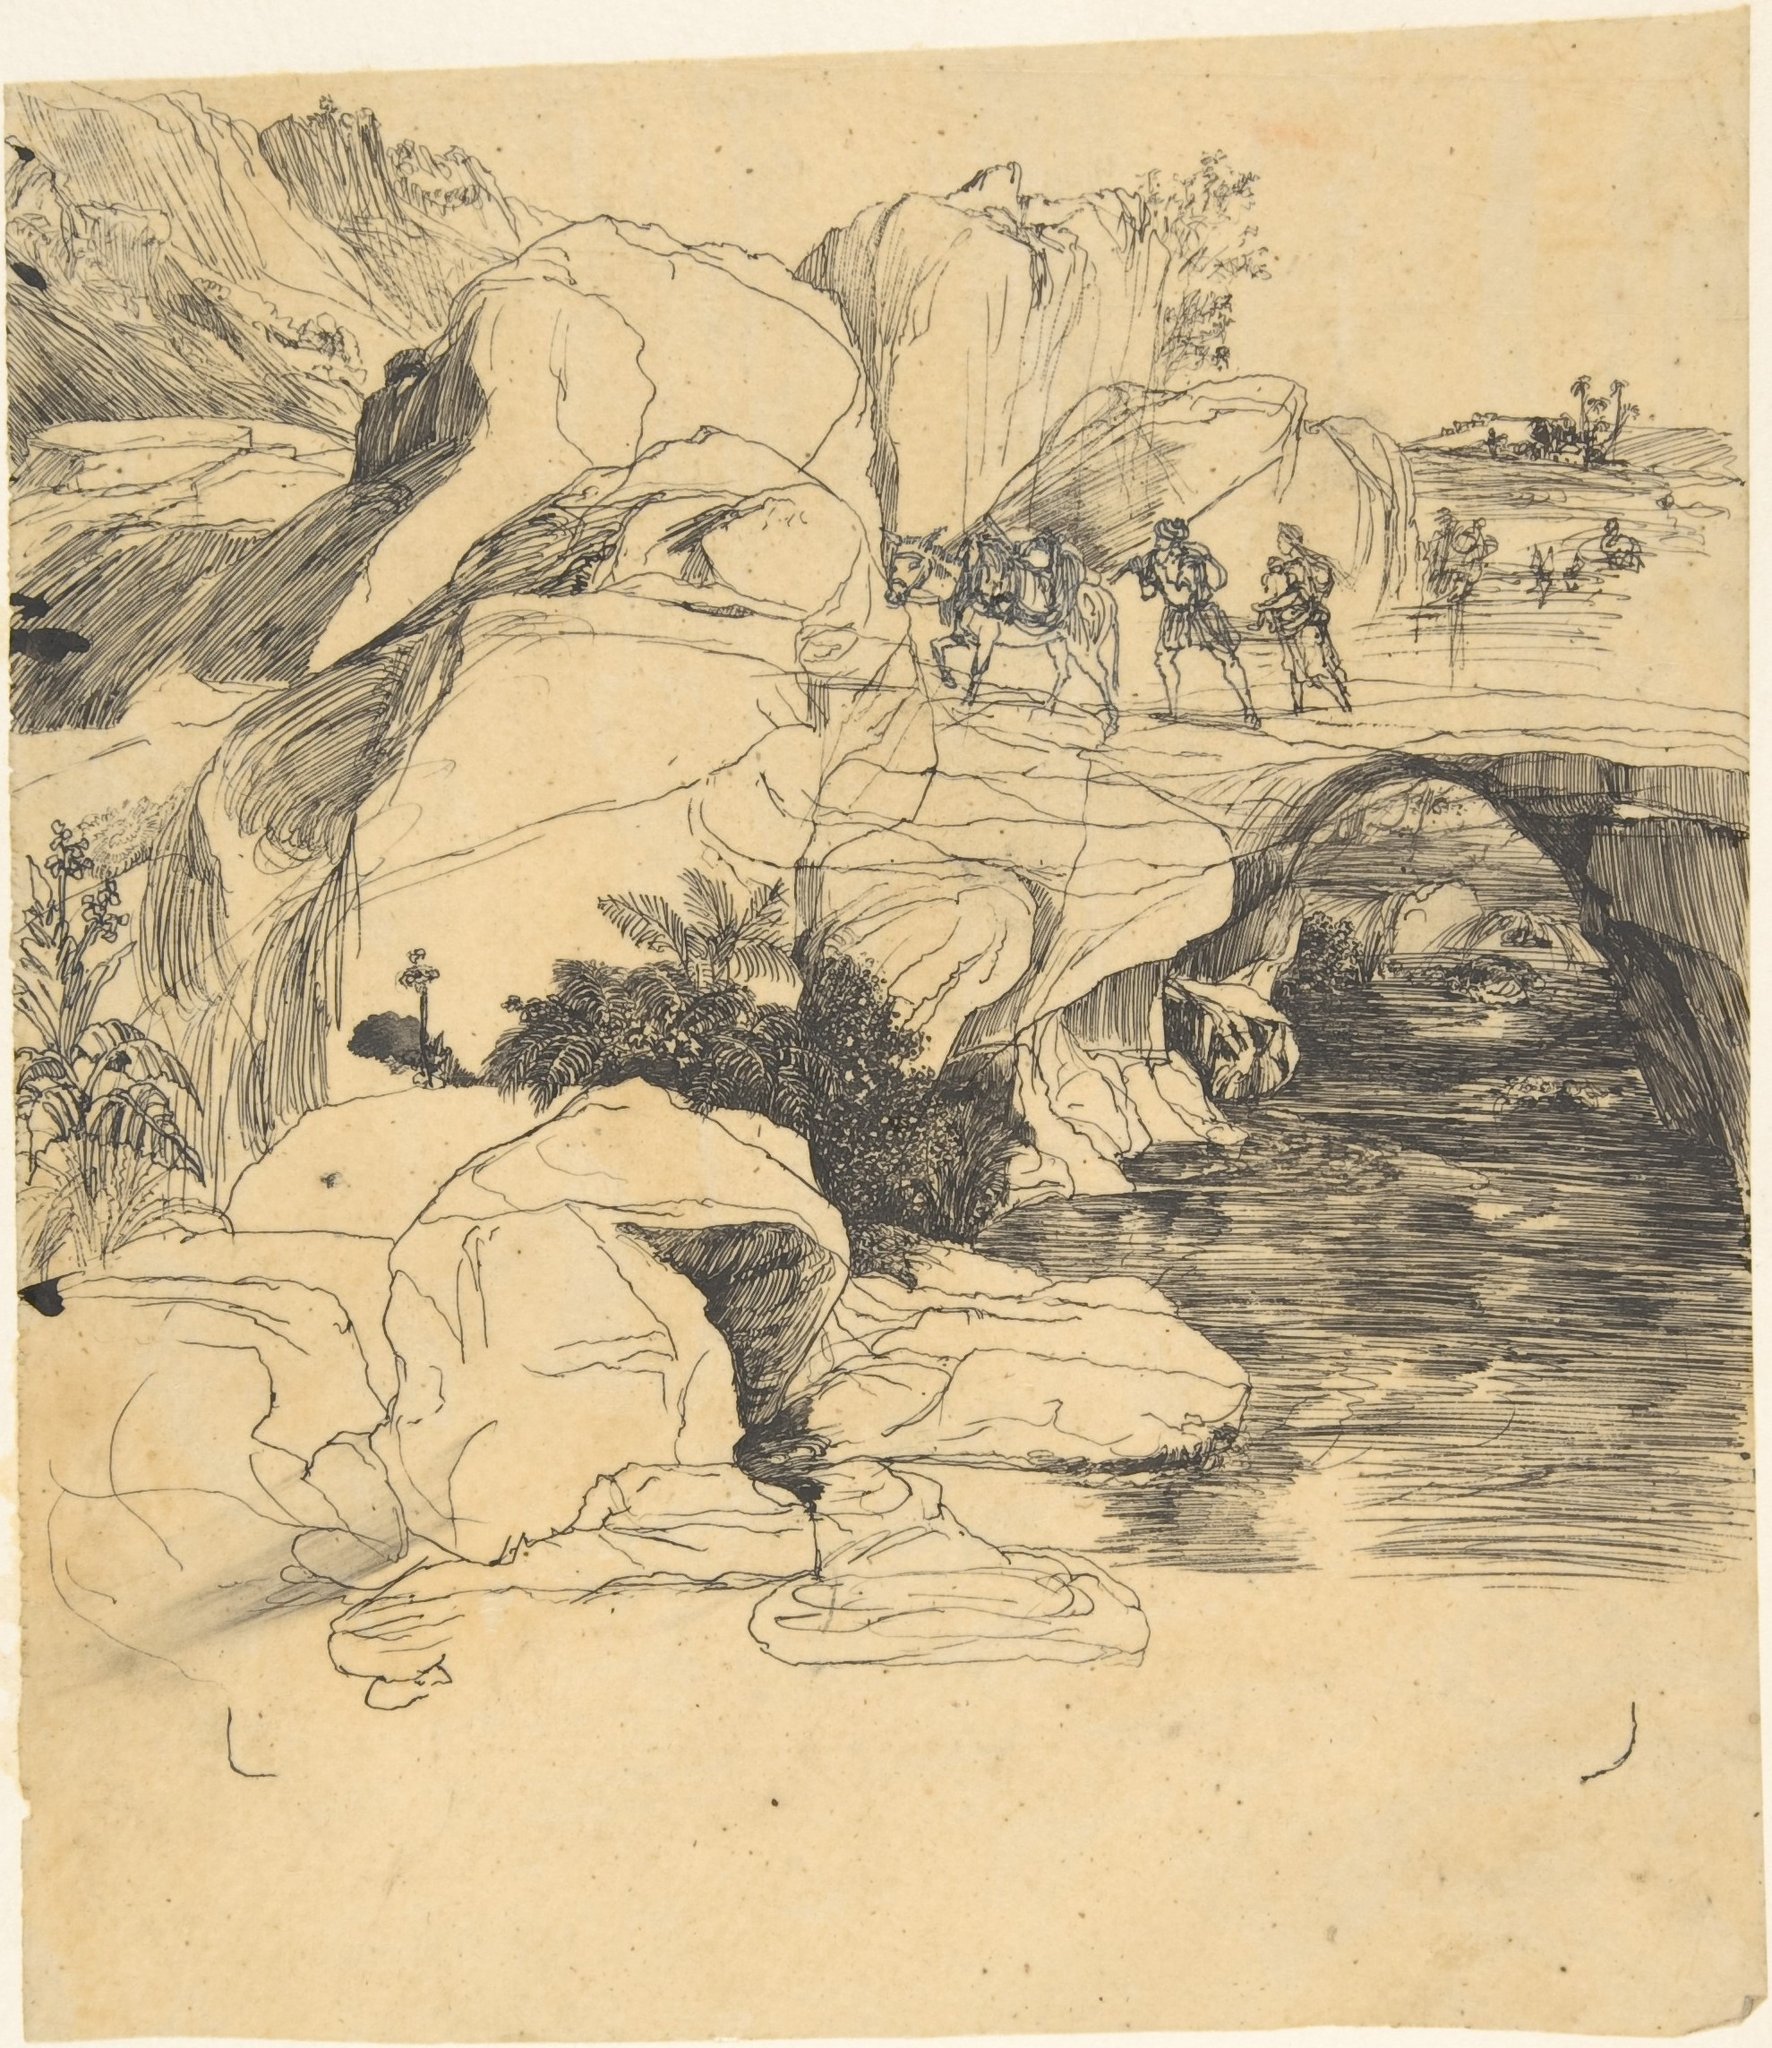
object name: drawing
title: The Mountain Stream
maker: rodolphe bresdin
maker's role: artist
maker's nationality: french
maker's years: 1822-1885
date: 1822-1885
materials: ink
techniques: pen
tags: men,horses,mountains,streams